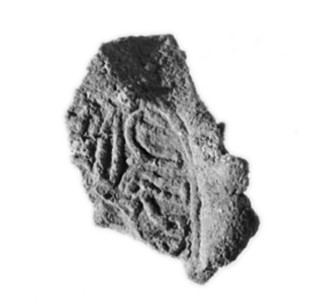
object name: sealing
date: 1981-1640 BCE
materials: mud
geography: egypt